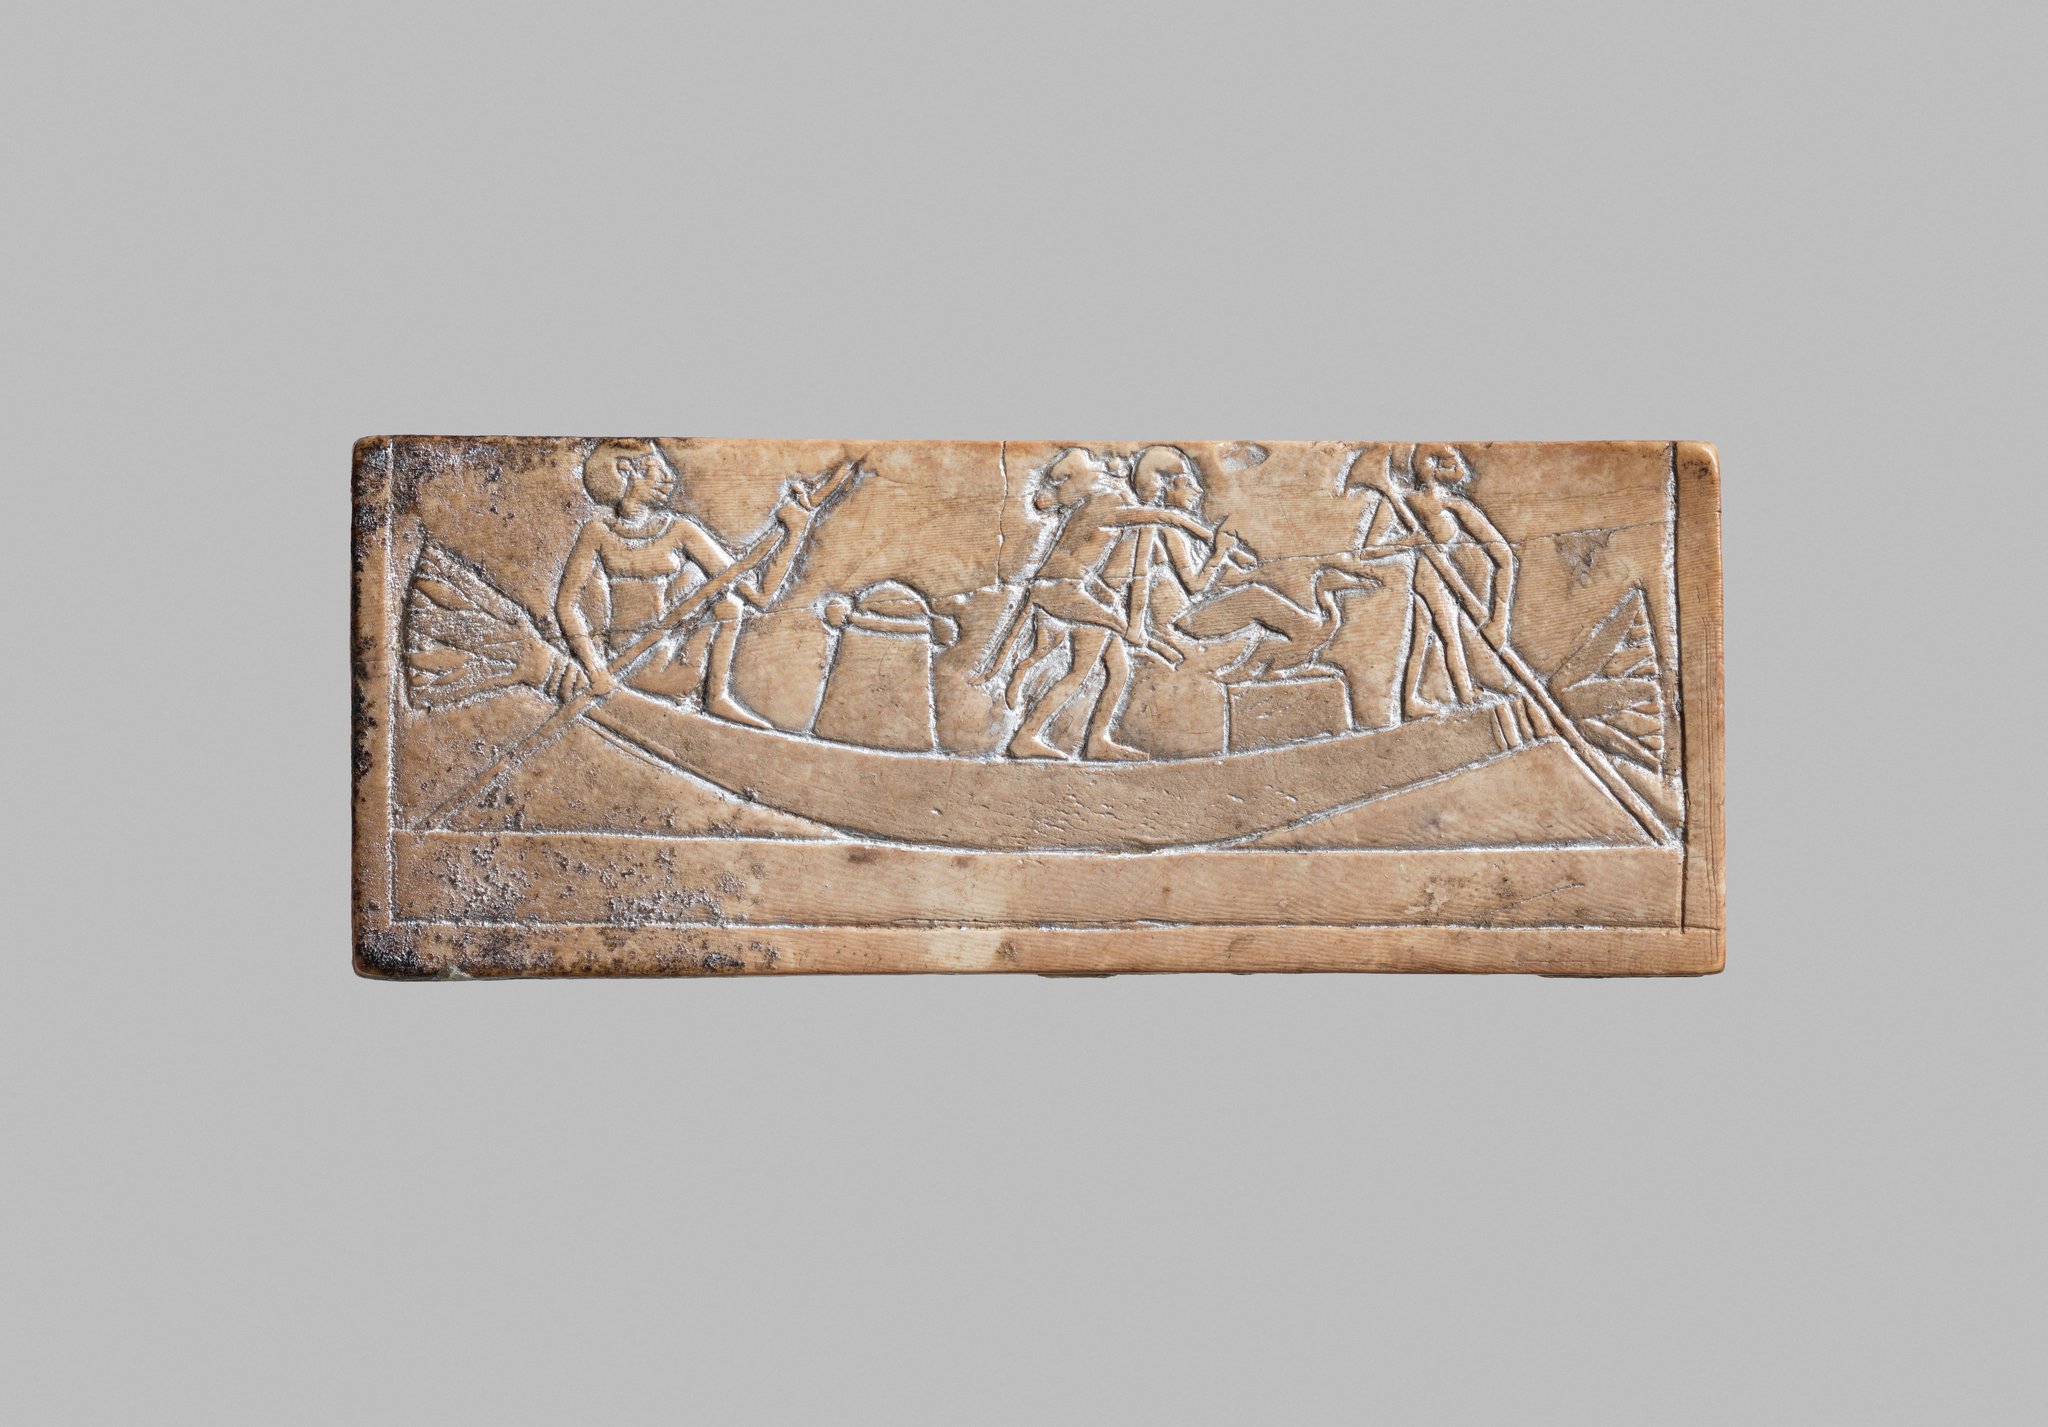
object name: plaque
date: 664-332 BCE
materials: ivory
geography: egypt